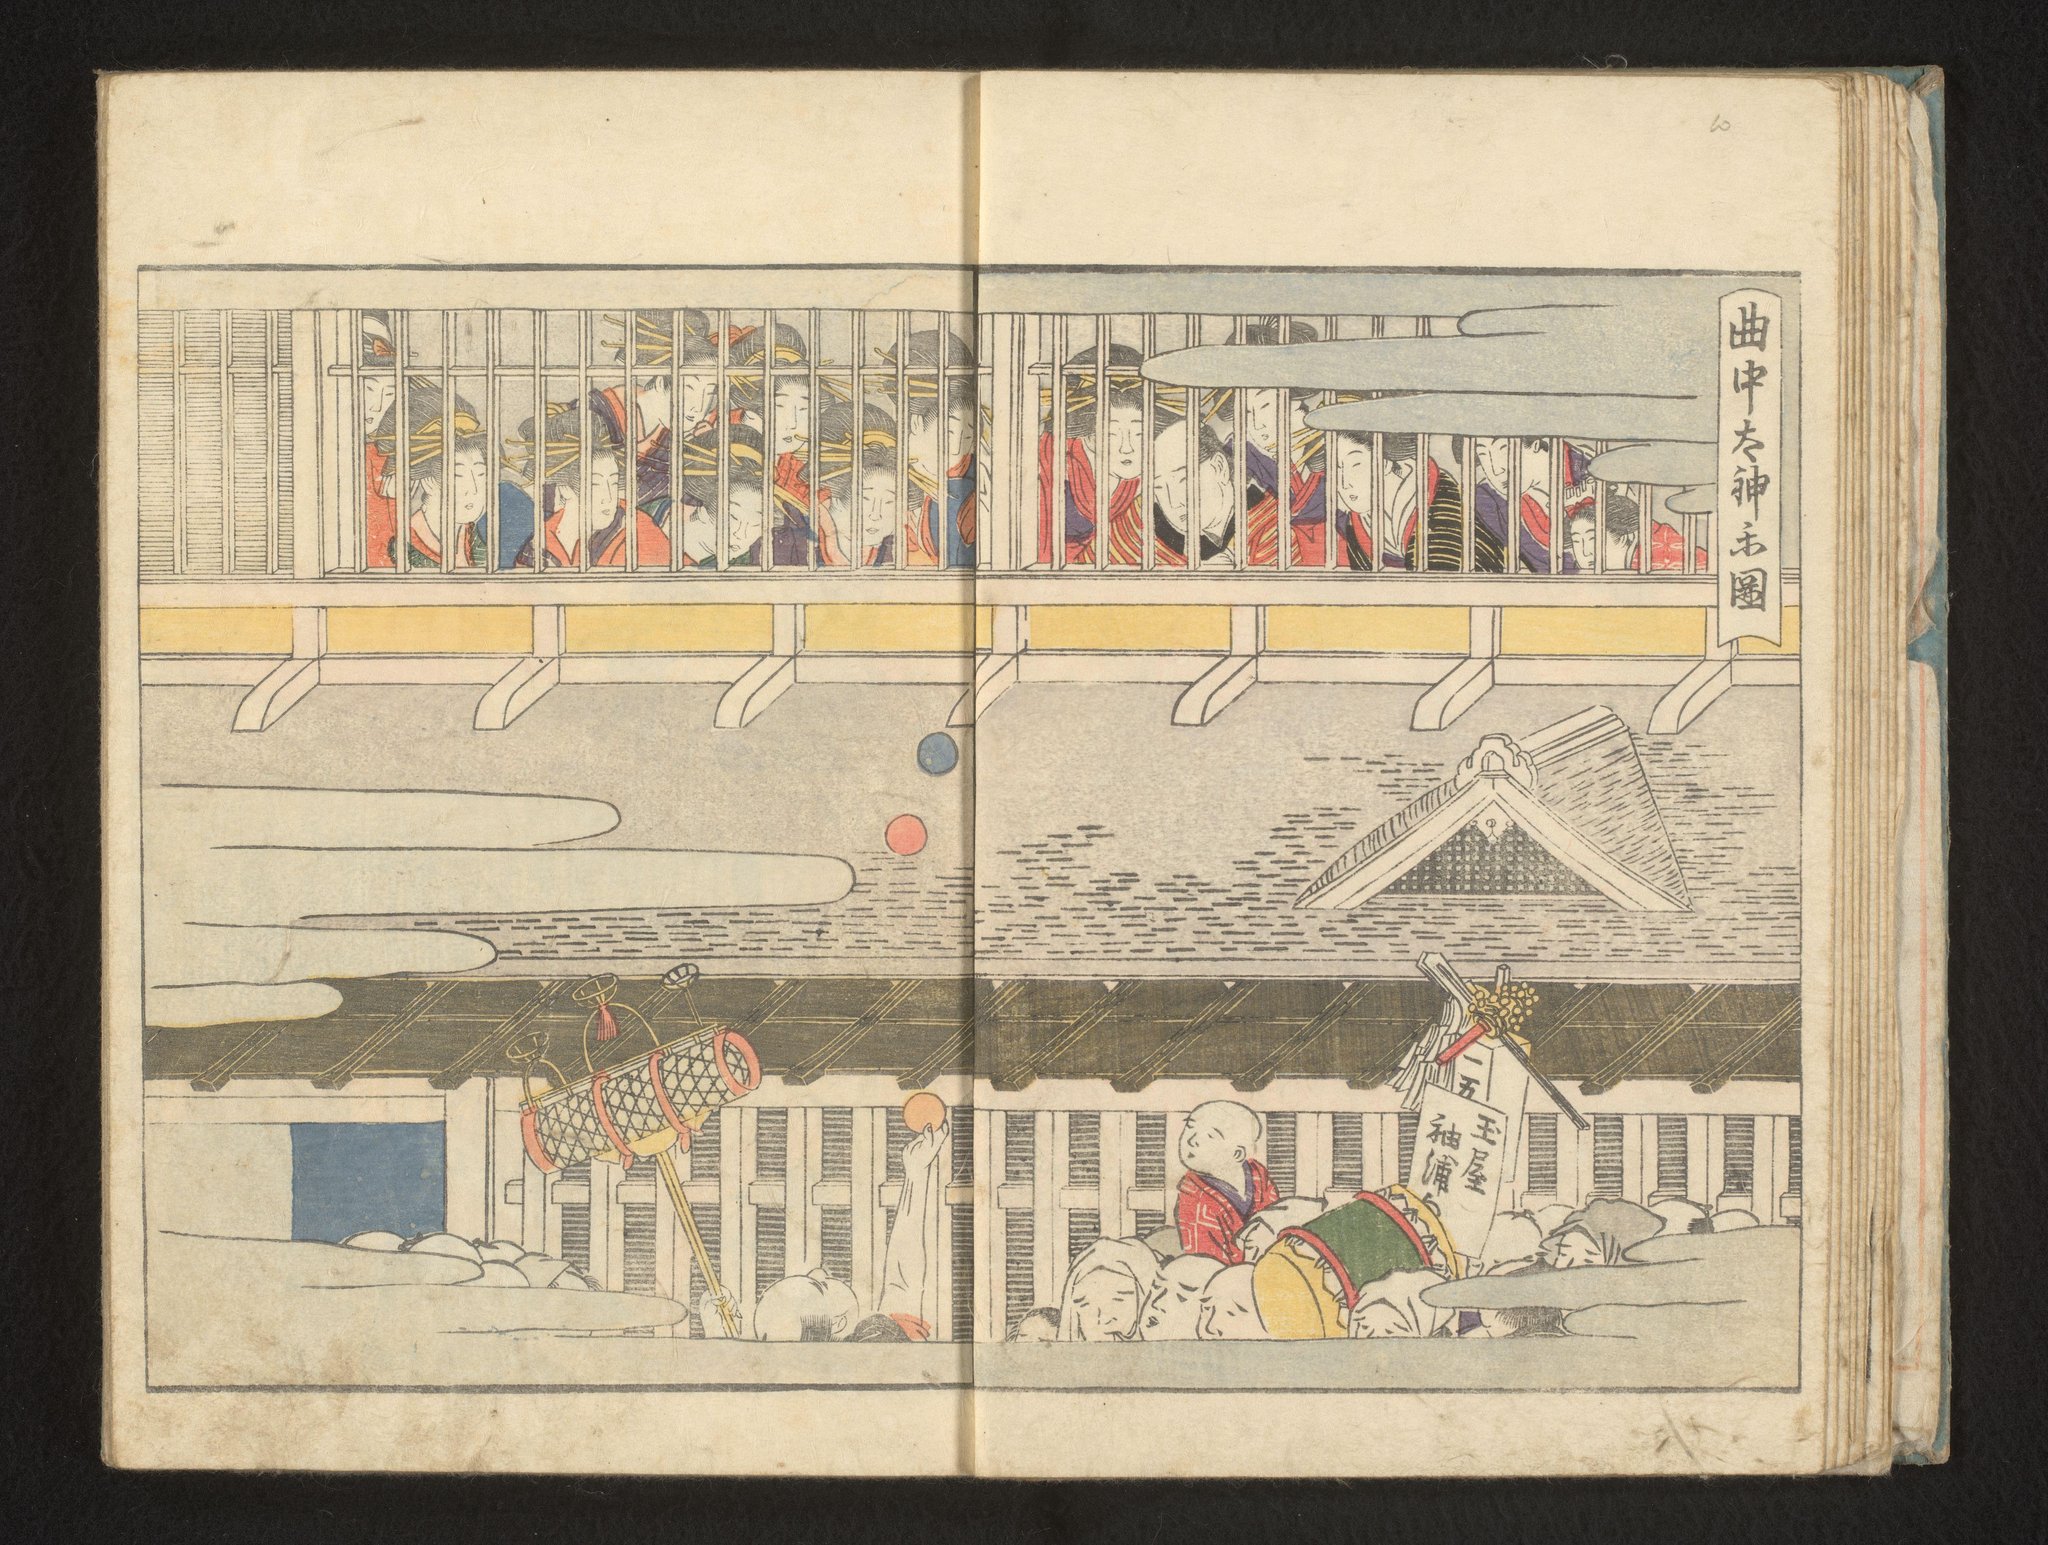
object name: page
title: De tweede verdieping van een bordeel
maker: kitagawa utamaro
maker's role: print maker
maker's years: 1753-1806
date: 1804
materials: paper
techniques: woodcut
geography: edo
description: Achttiende en negentiende pagina van deel één van Utamaro`s boek: Gebeurtenissen in de lusthuizen gedurende het jaar.